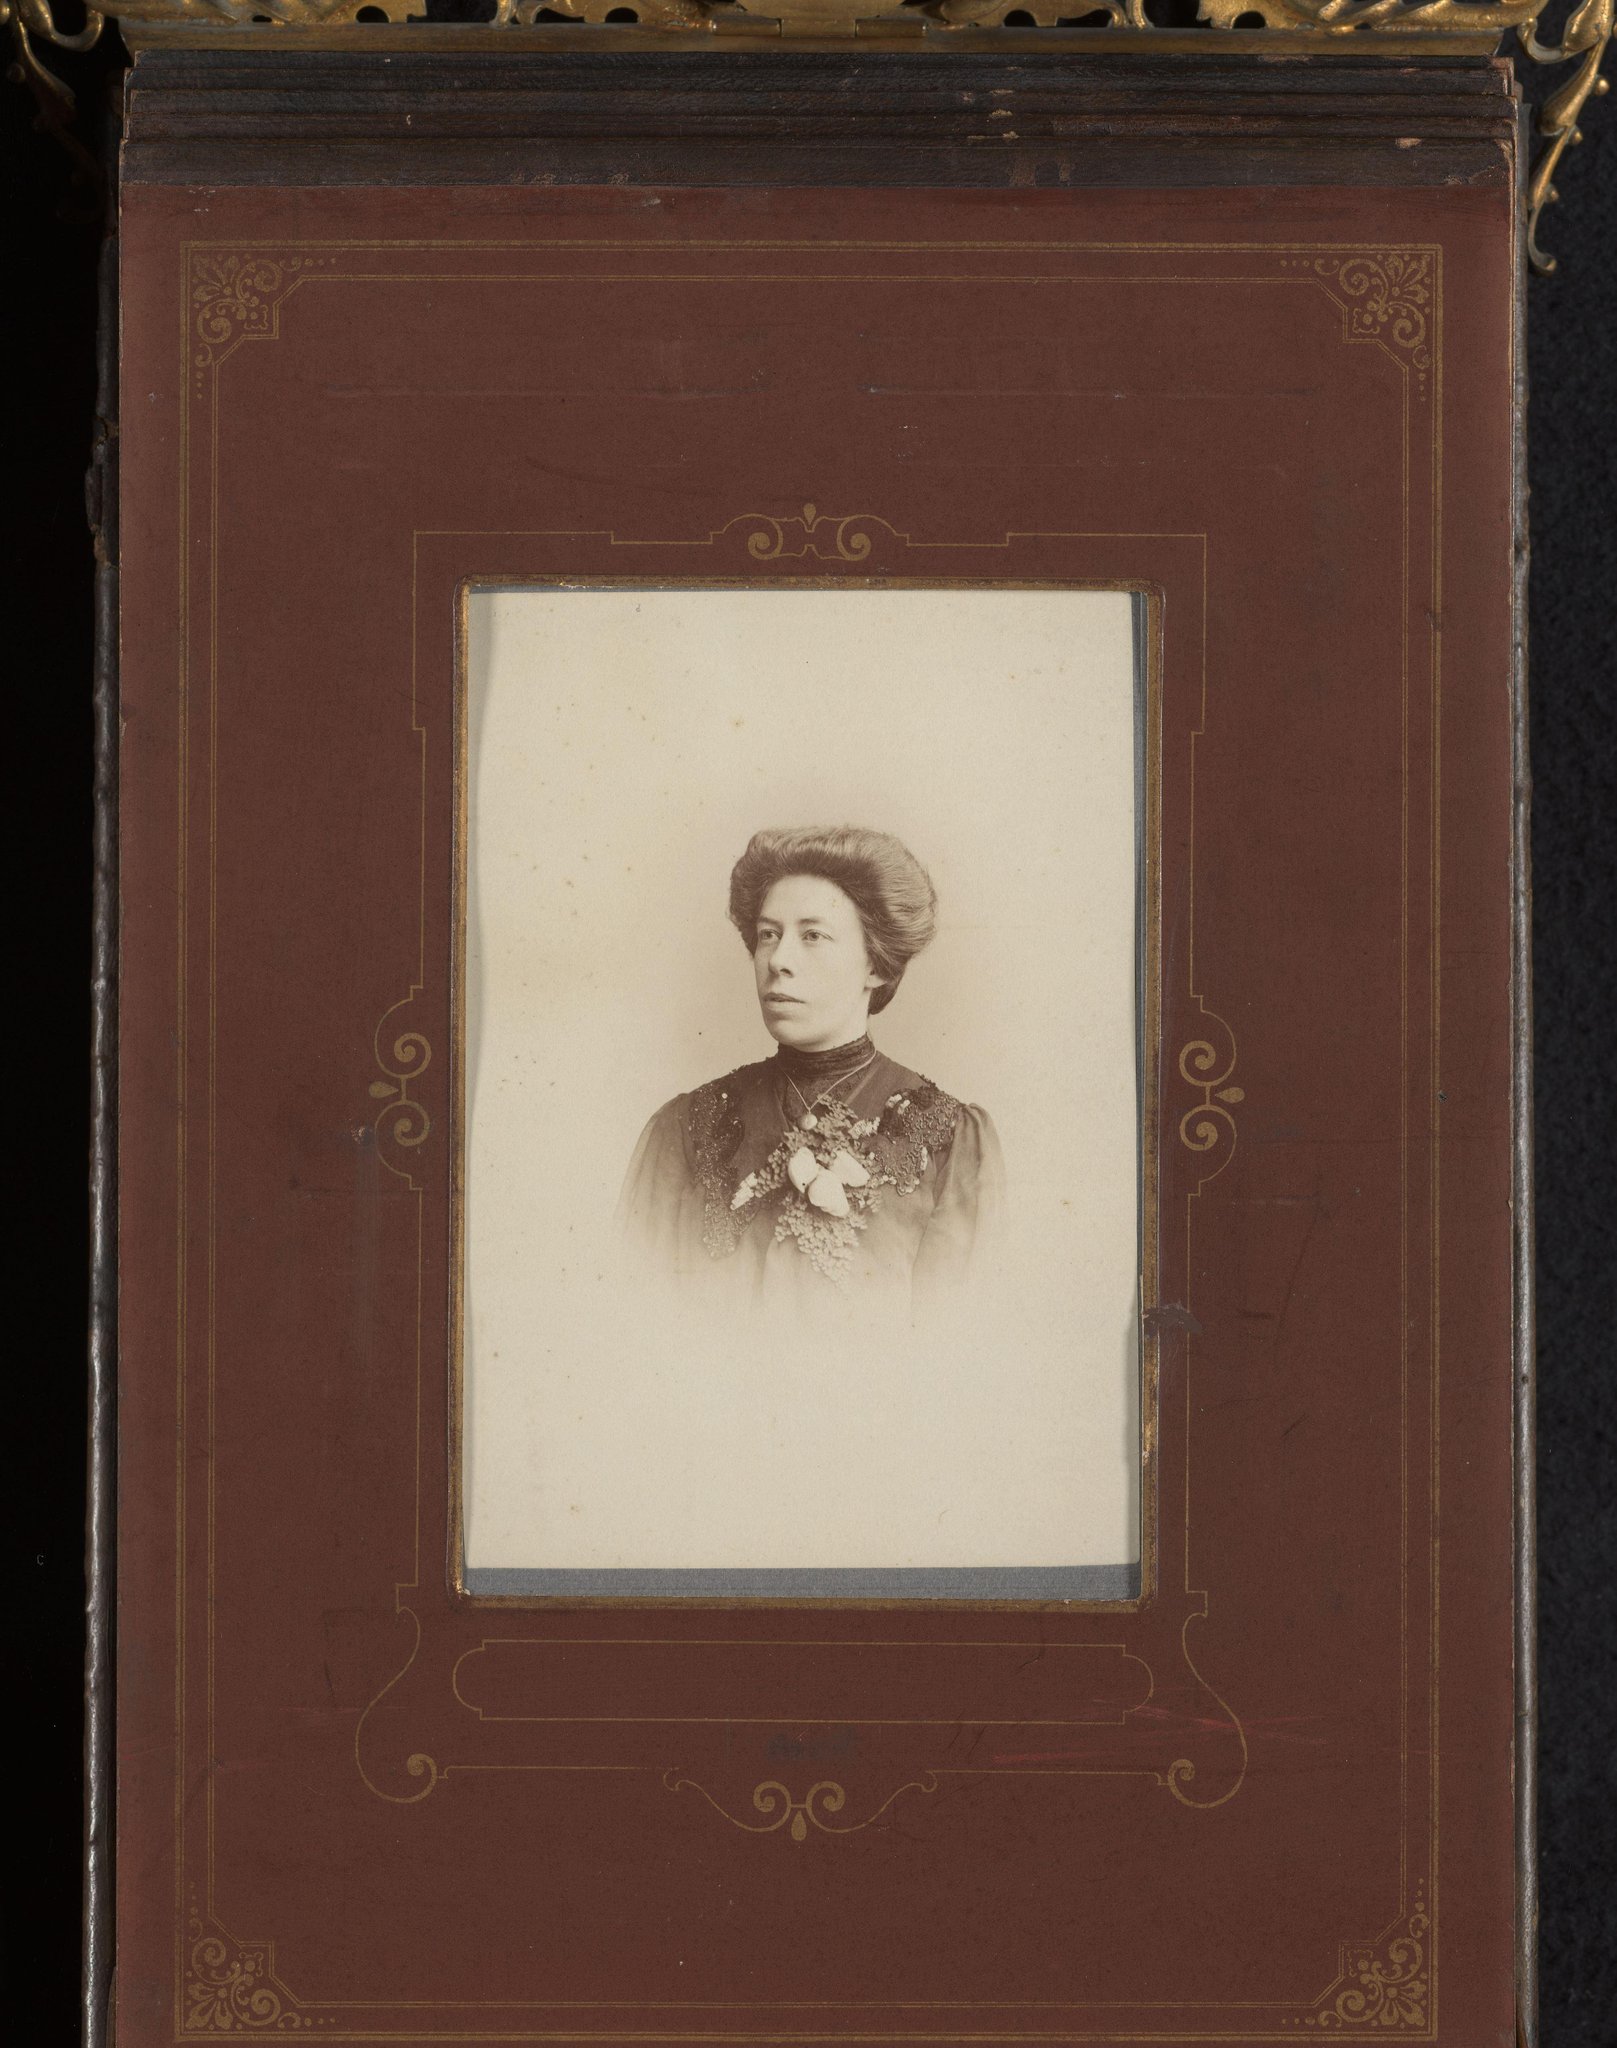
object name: photograph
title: Portret van een vrouw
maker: j.h. gill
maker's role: fotograaf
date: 1860-1900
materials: cardboard, photographic support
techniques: albumen print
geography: bury saint edmunds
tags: historical persons - bb - woman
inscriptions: inscription: ‘J.H. Gill/ 77 Whiting St./ Bury St. Edmunds’